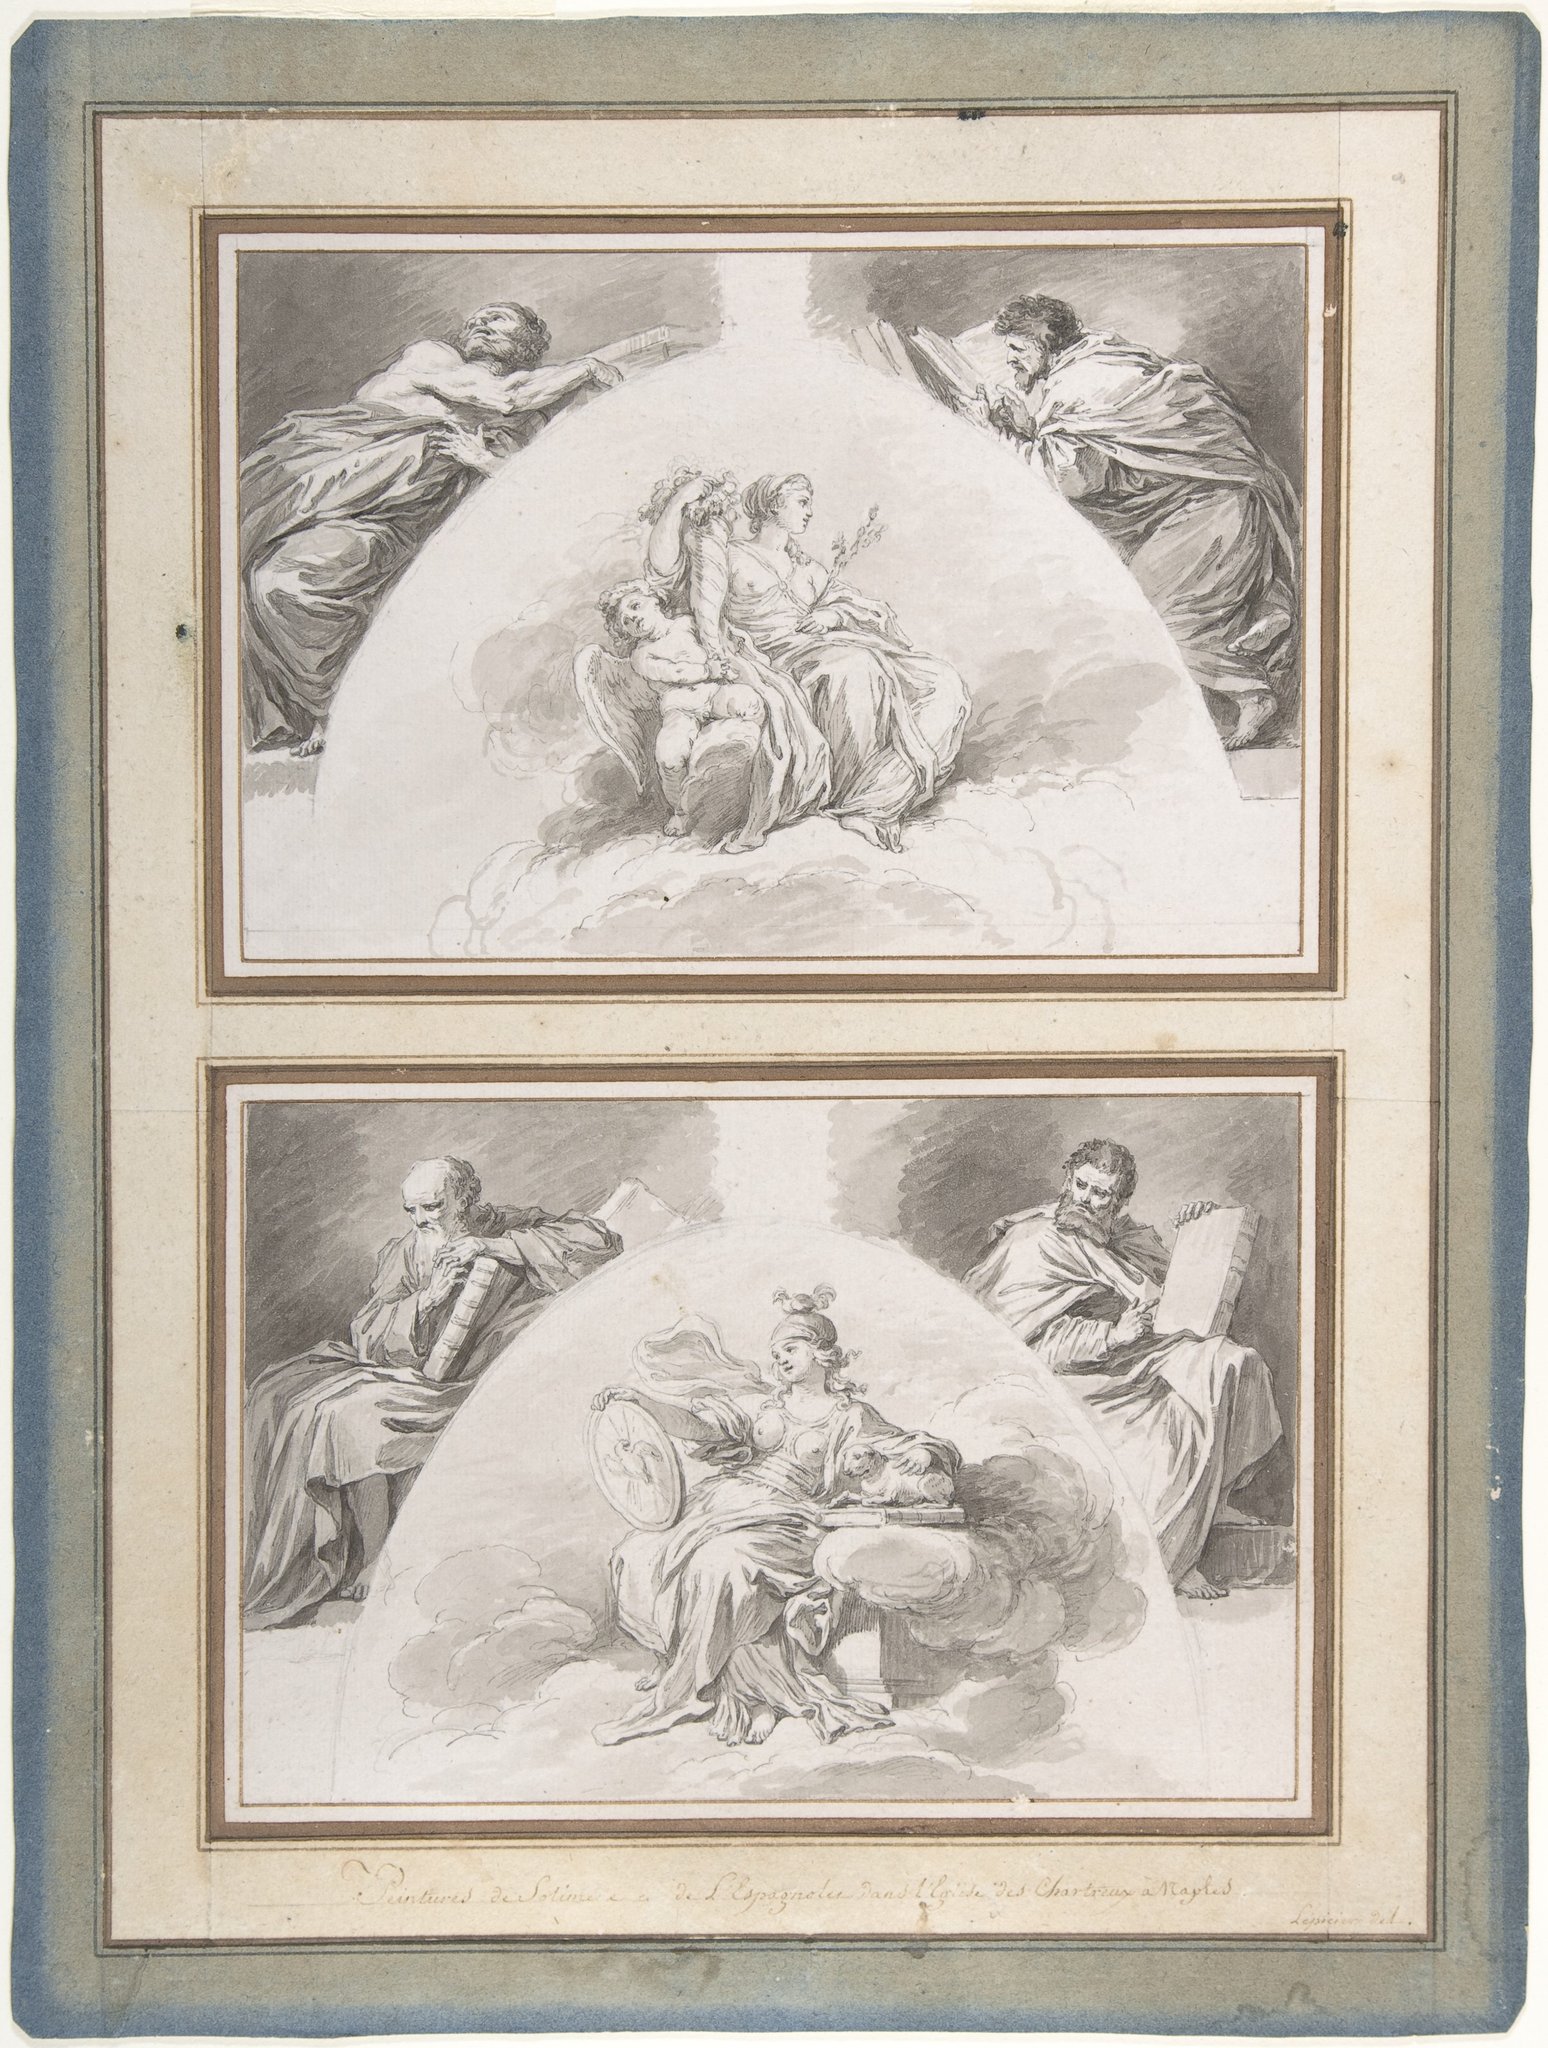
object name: drawing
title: Copies after Jusepe de Ribera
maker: nicolas bernard lépicié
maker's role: artist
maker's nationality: french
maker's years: 1735-1784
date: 1701-1800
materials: graphite, ink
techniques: pen, wash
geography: france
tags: men,women,putti